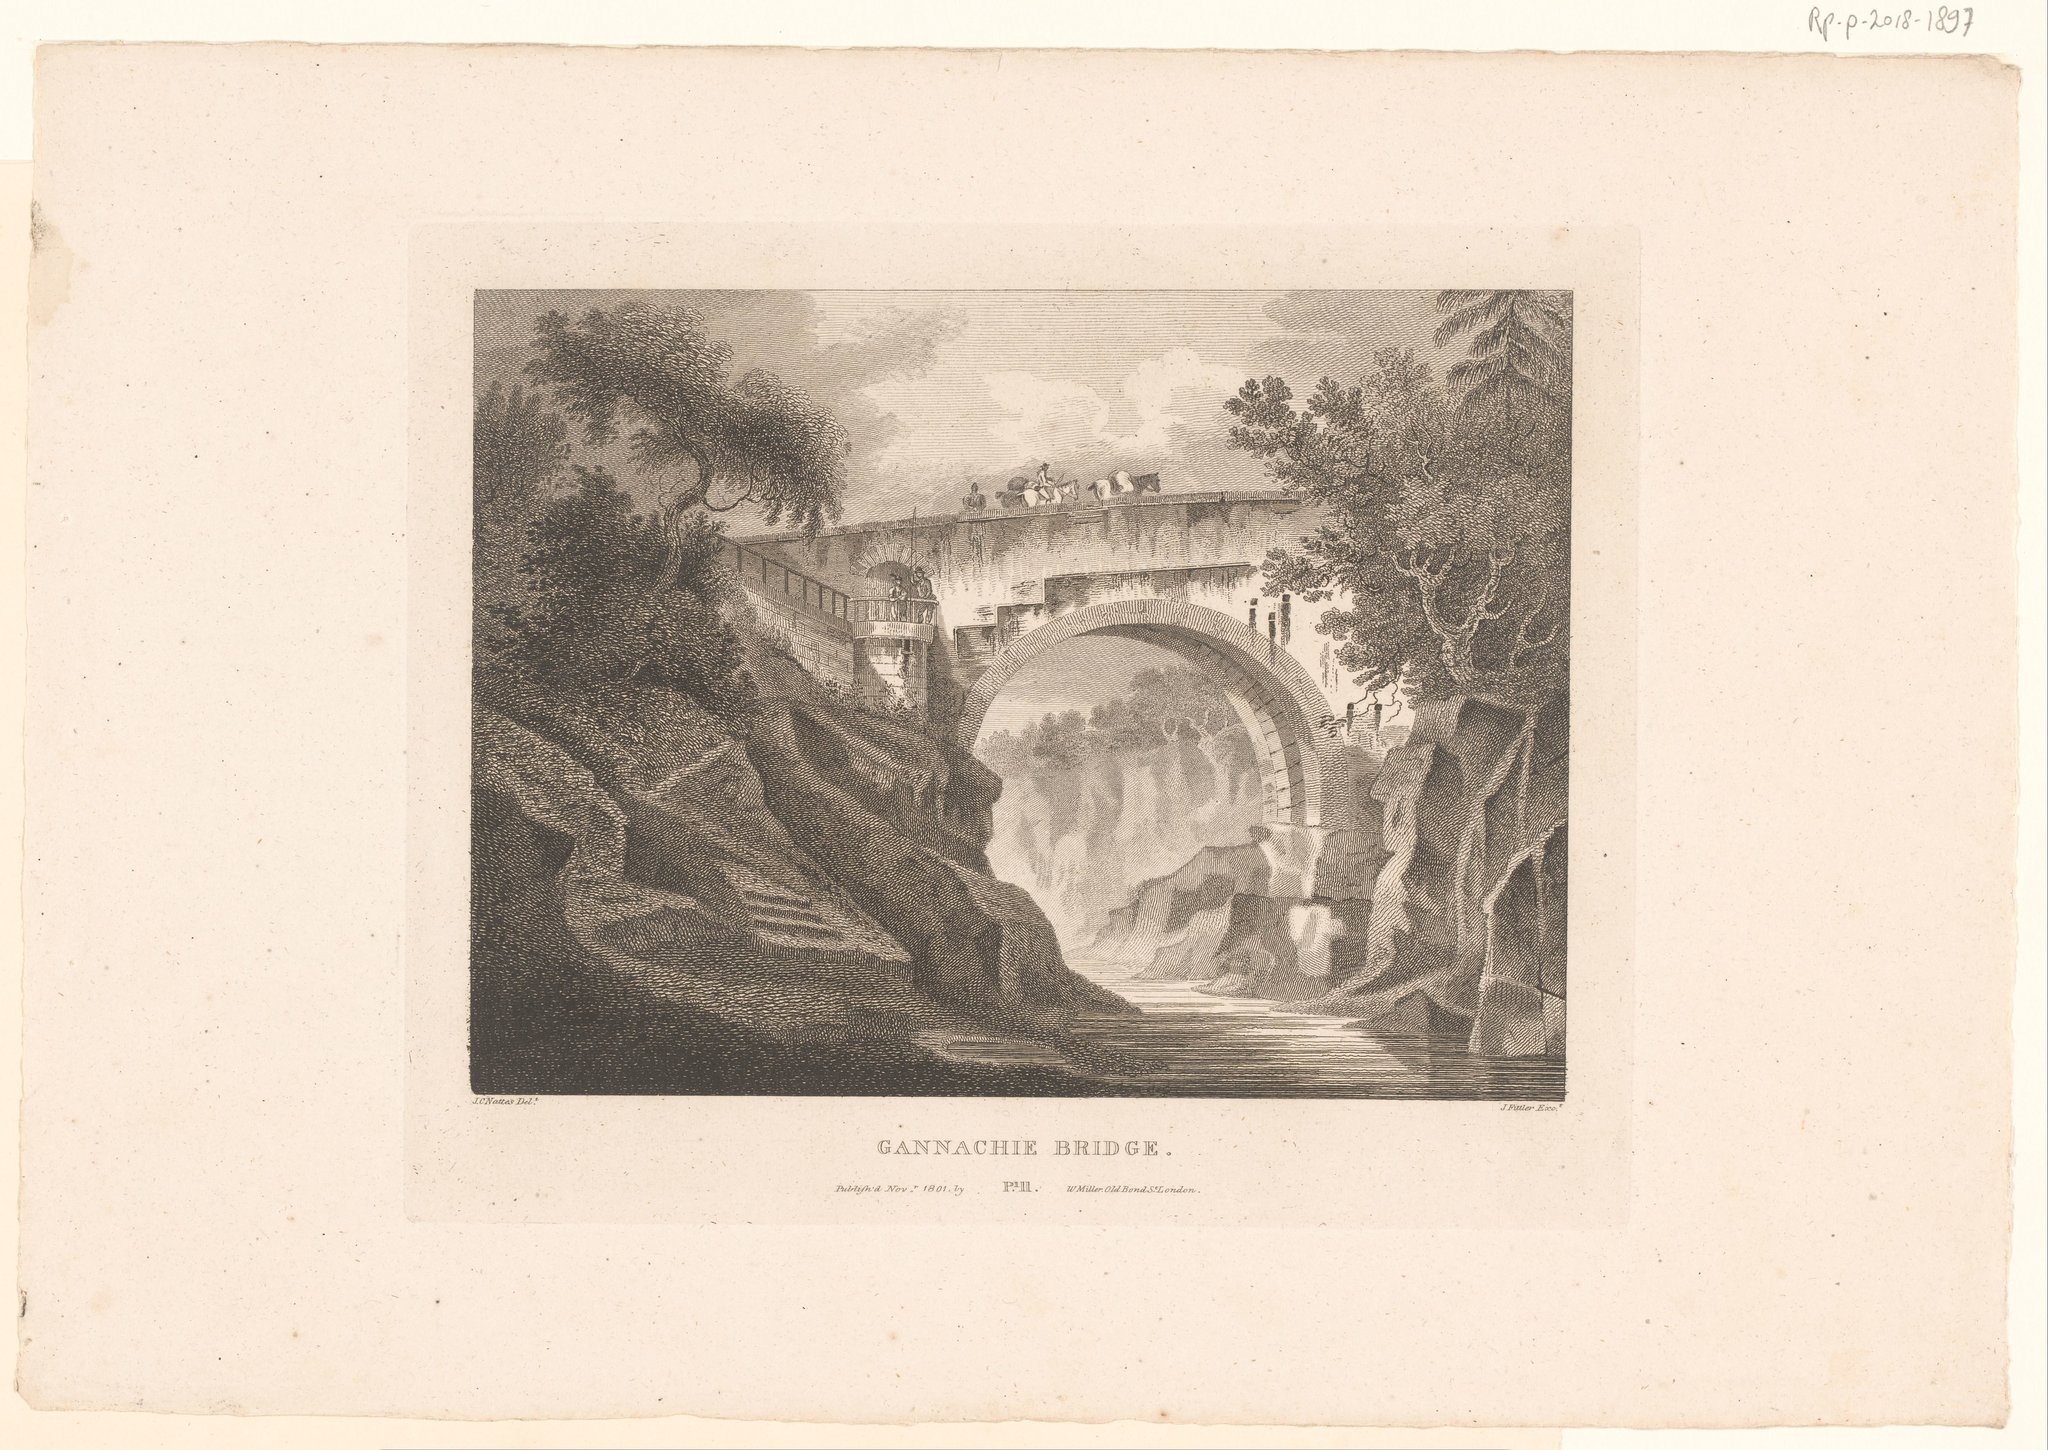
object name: print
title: Gezicht op Gannachie Bridge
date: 1801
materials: paper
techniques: engraving, etching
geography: london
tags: road, path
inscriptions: collector's mark: Lugt 2228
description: Prent gebruikt in: Scotia Depicta; or the antiquities, castles, public buildings, noblemen (...). Londen: William Miller, 1801. Zie ook: RP-P-2018-1898.